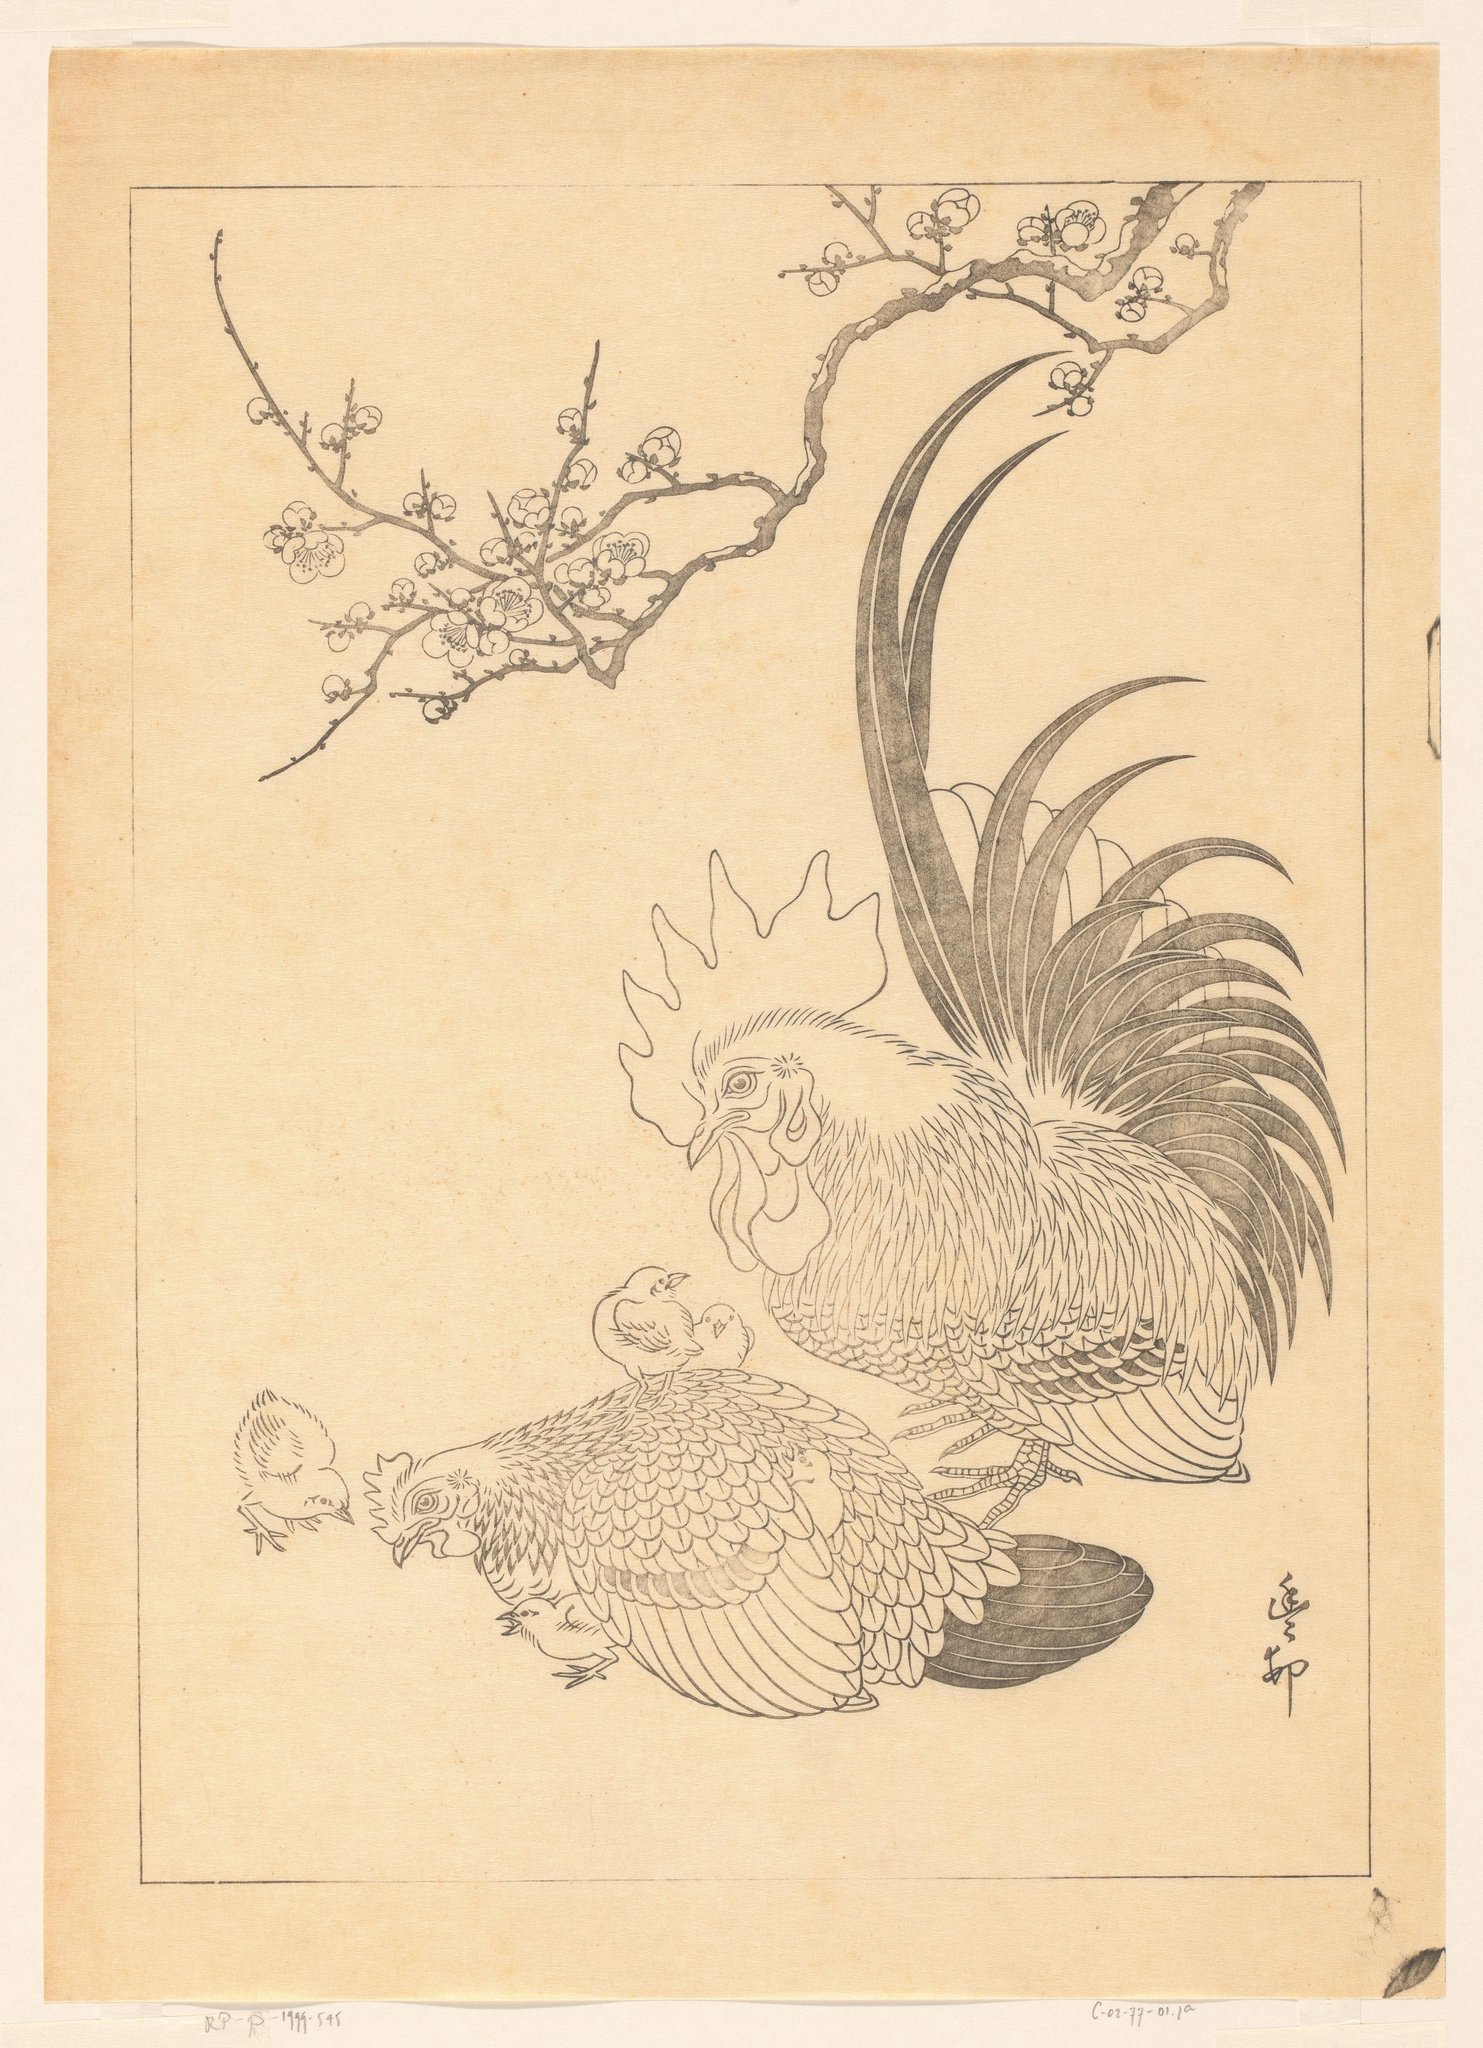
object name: print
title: Haan met hen en vijf kuikens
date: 1926-1945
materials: paper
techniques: woodcut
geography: japan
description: Haan met hen en vijf kuikentjes onder bloesemtak.